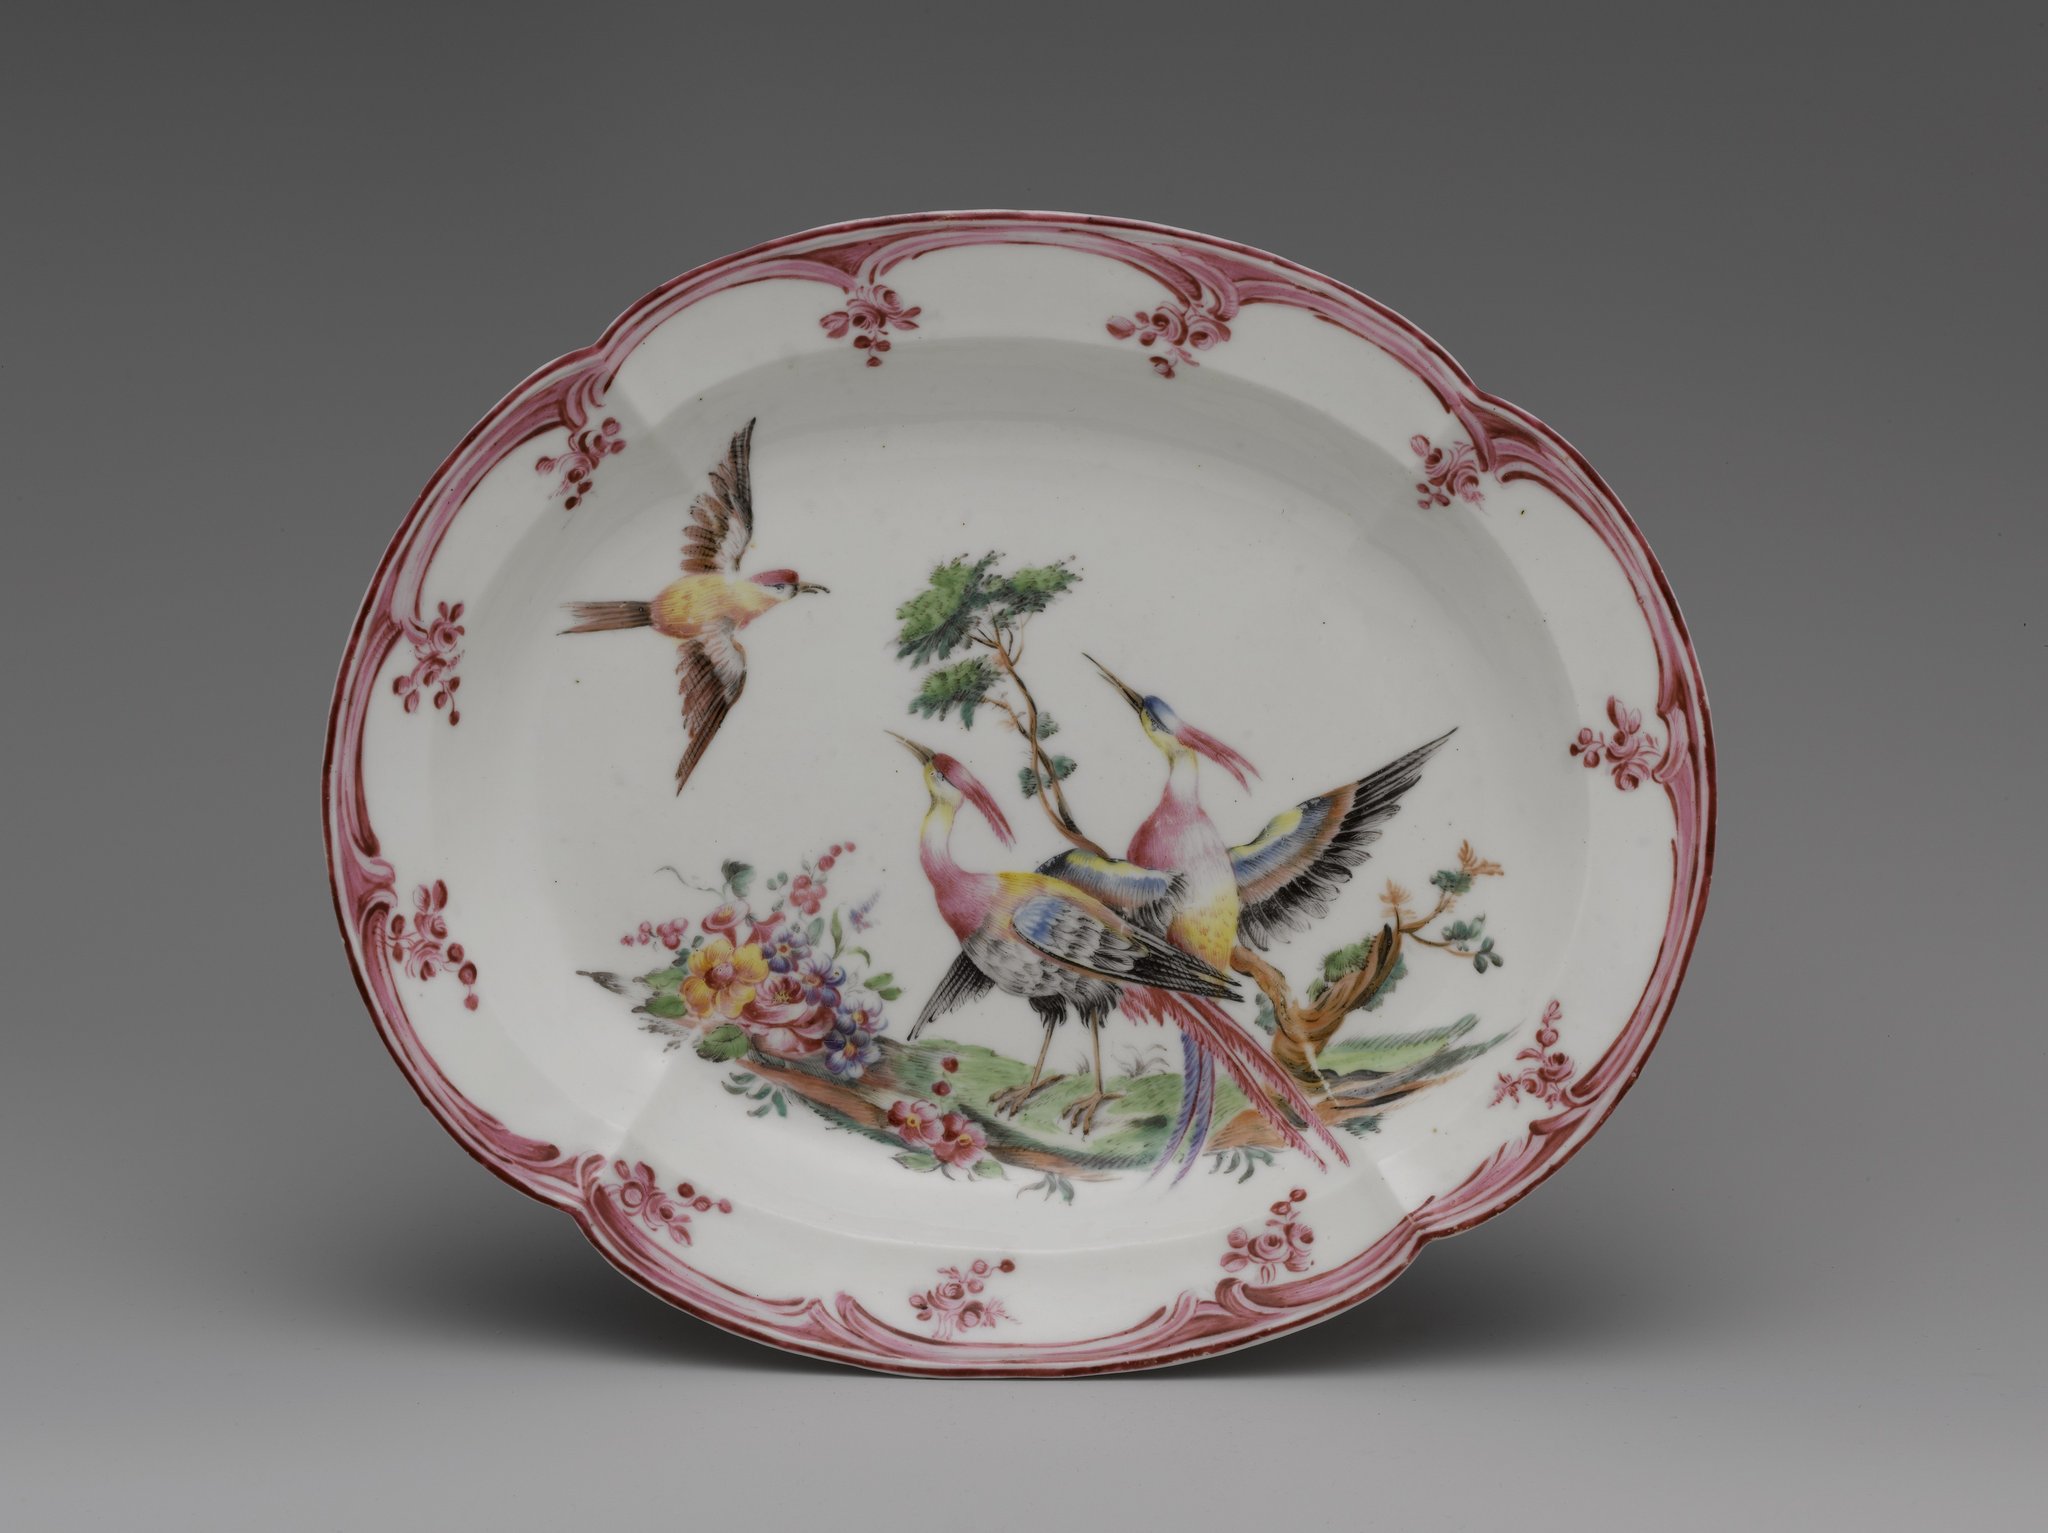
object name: stand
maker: mennecy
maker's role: factory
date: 1760-1765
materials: enamel, soft paste porcelain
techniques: polychrome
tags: birds,flowers,plants